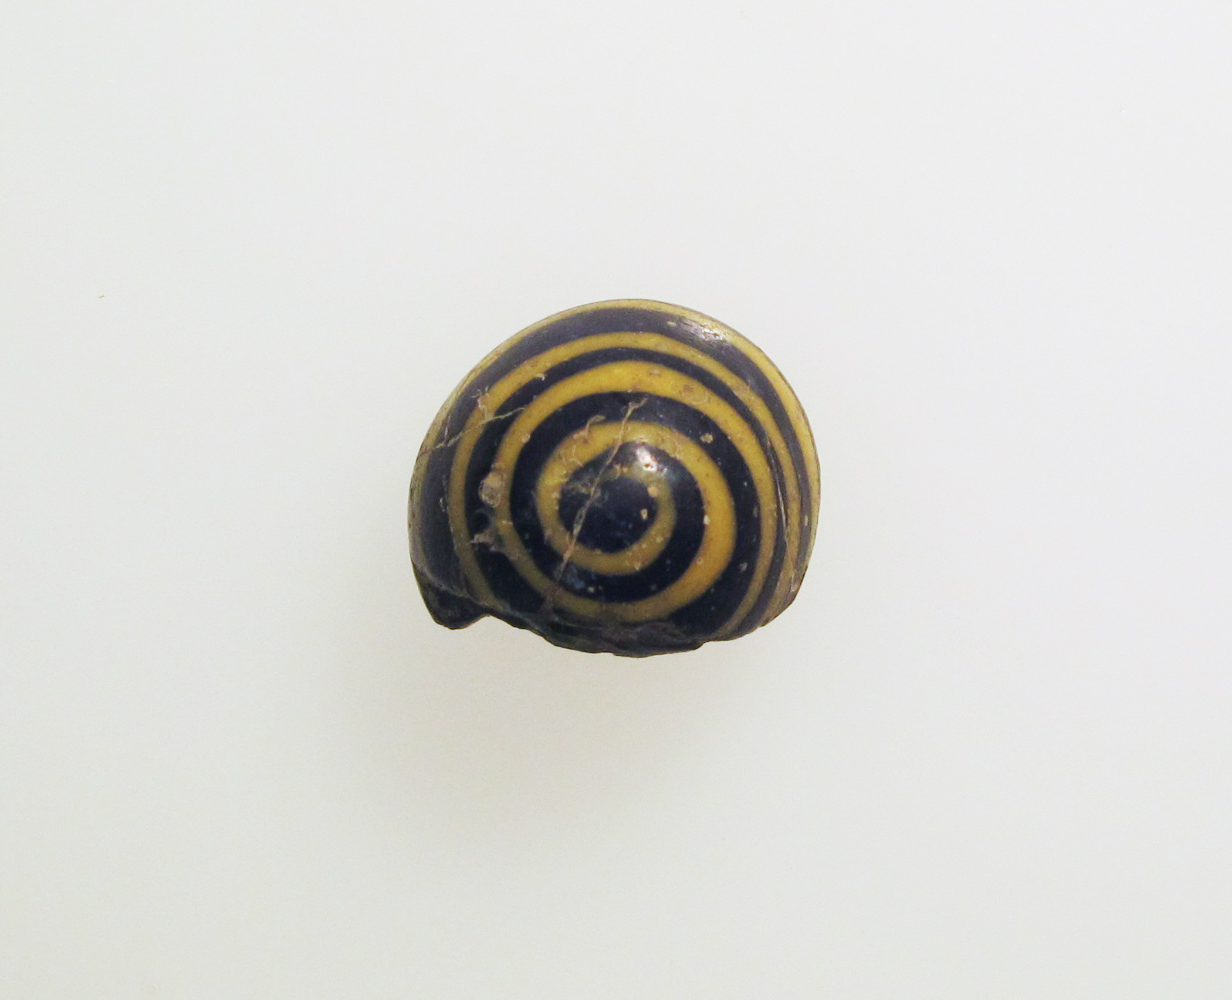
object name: pinhead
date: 7000 BCE-330 CE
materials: glass